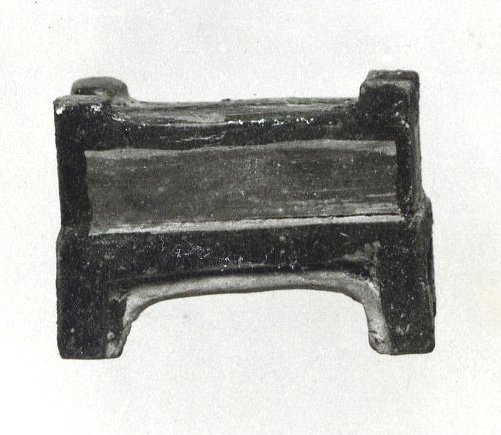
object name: model chest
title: Painted Model Chest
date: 2030-1640 BCE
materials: paint, wood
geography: egypt